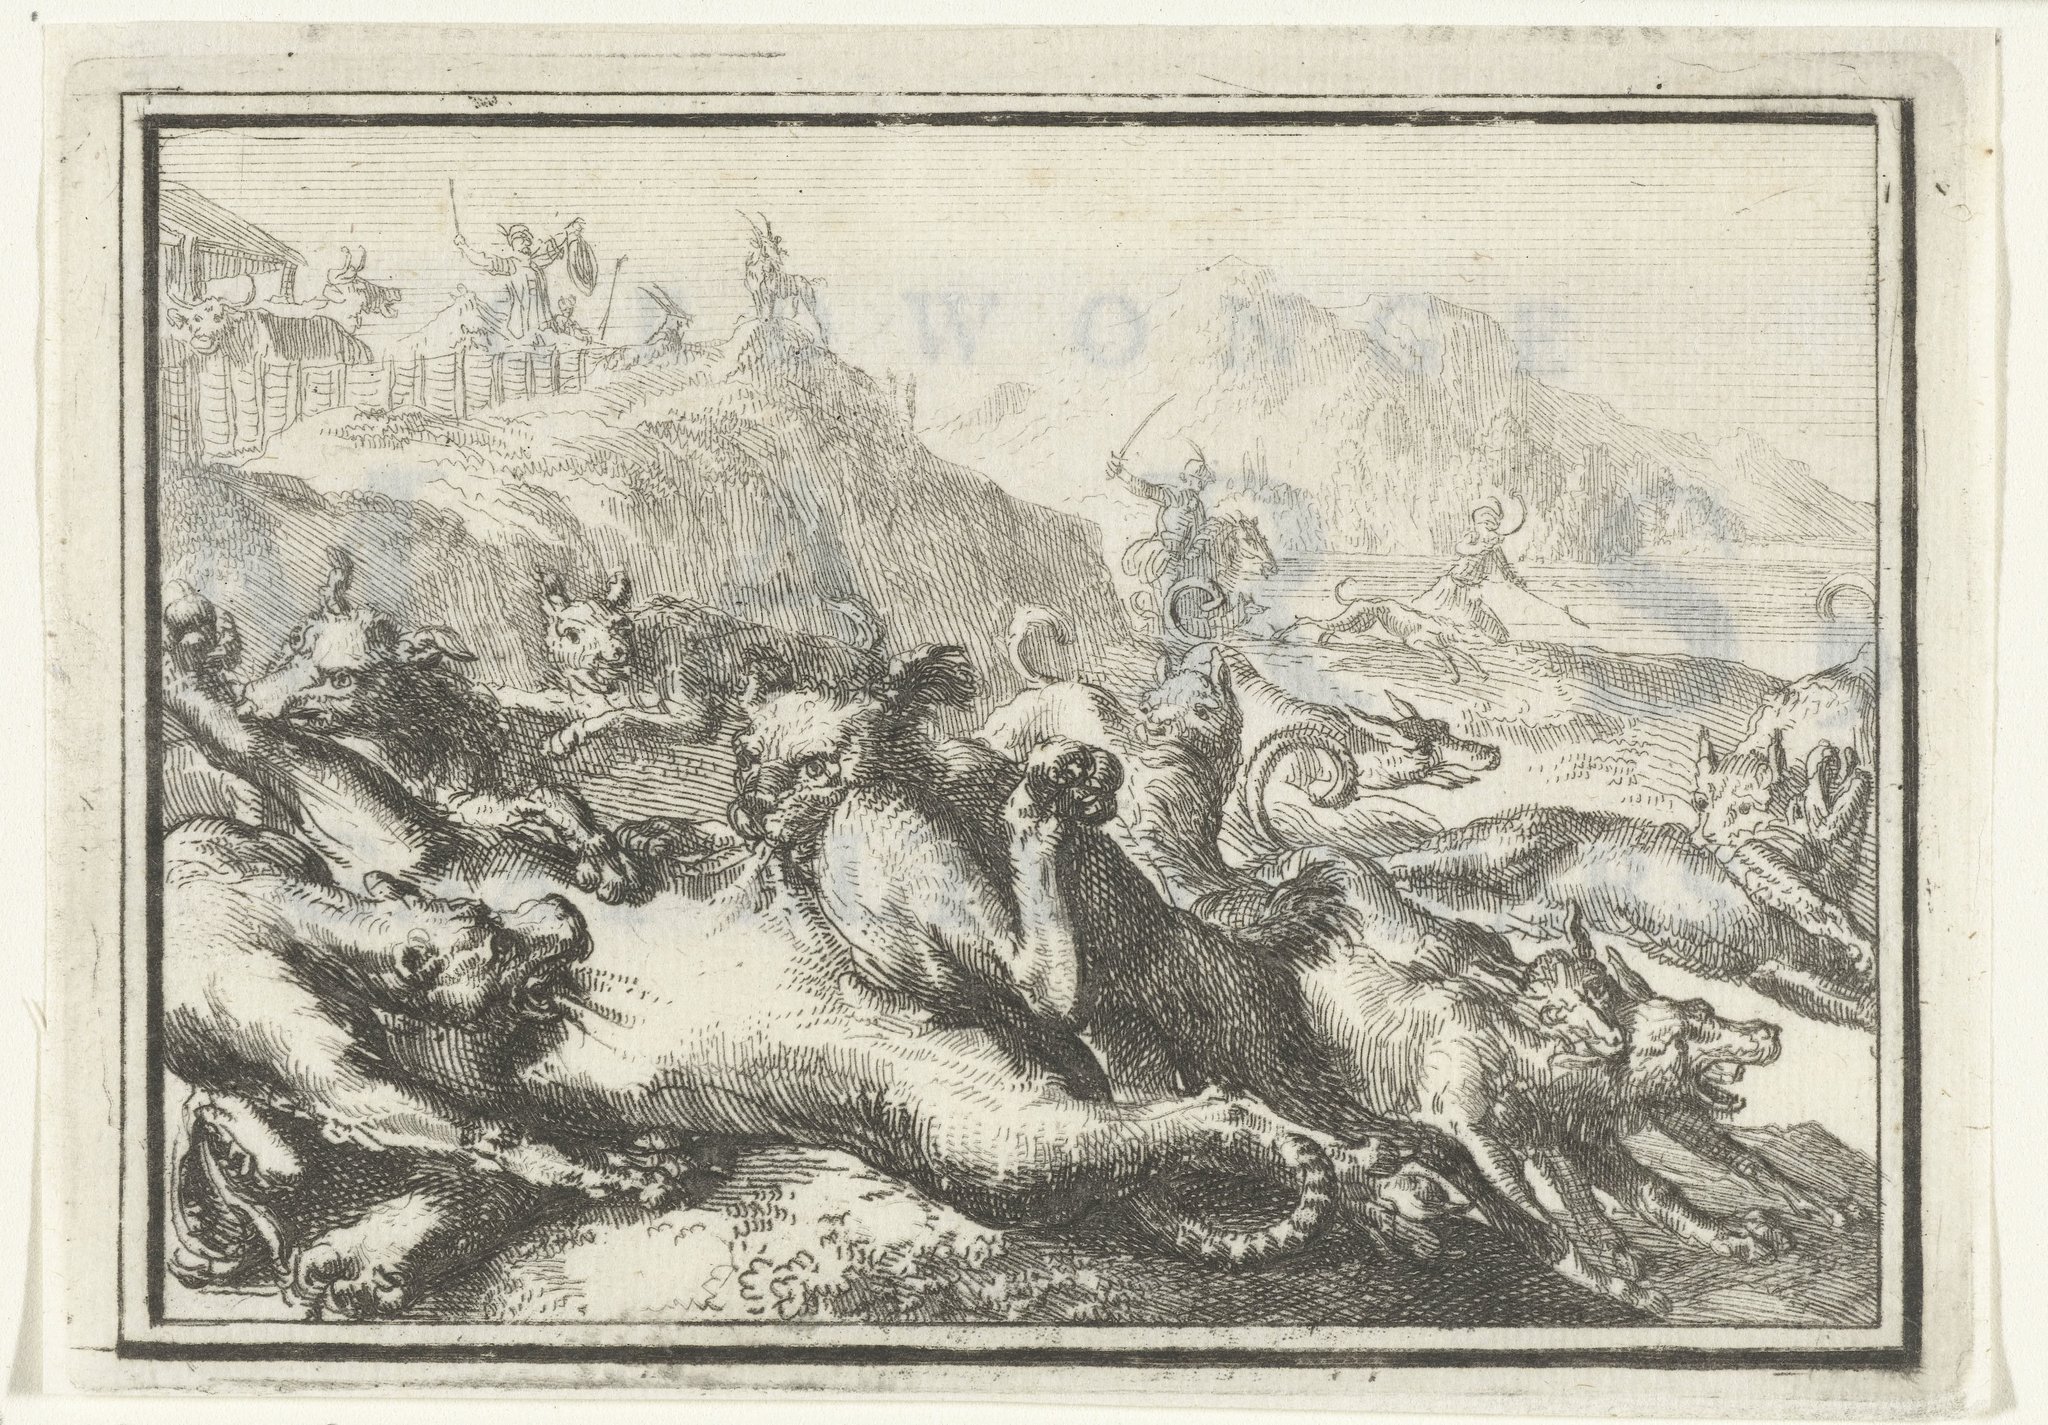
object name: print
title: Gedwonge Mars, gaat altyd dwars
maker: romeyn de hooghe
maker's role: draughtsman, goldsmith, painter, print maker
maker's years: 1645-1708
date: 1702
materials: paper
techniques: engraving, etching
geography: netherlands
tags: fables of aesop : use 85(...)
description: Vechtende dieren. Verbeelding van de fabel waarin de tijger en wolven honden dwingen om voor hen te roven maar uiteindelijk zelf door de honden worden verscheurd. Naar aanleiding van de dienstplicht zonder soldij in Frankrijk. Titel staat op apart tekstblad.